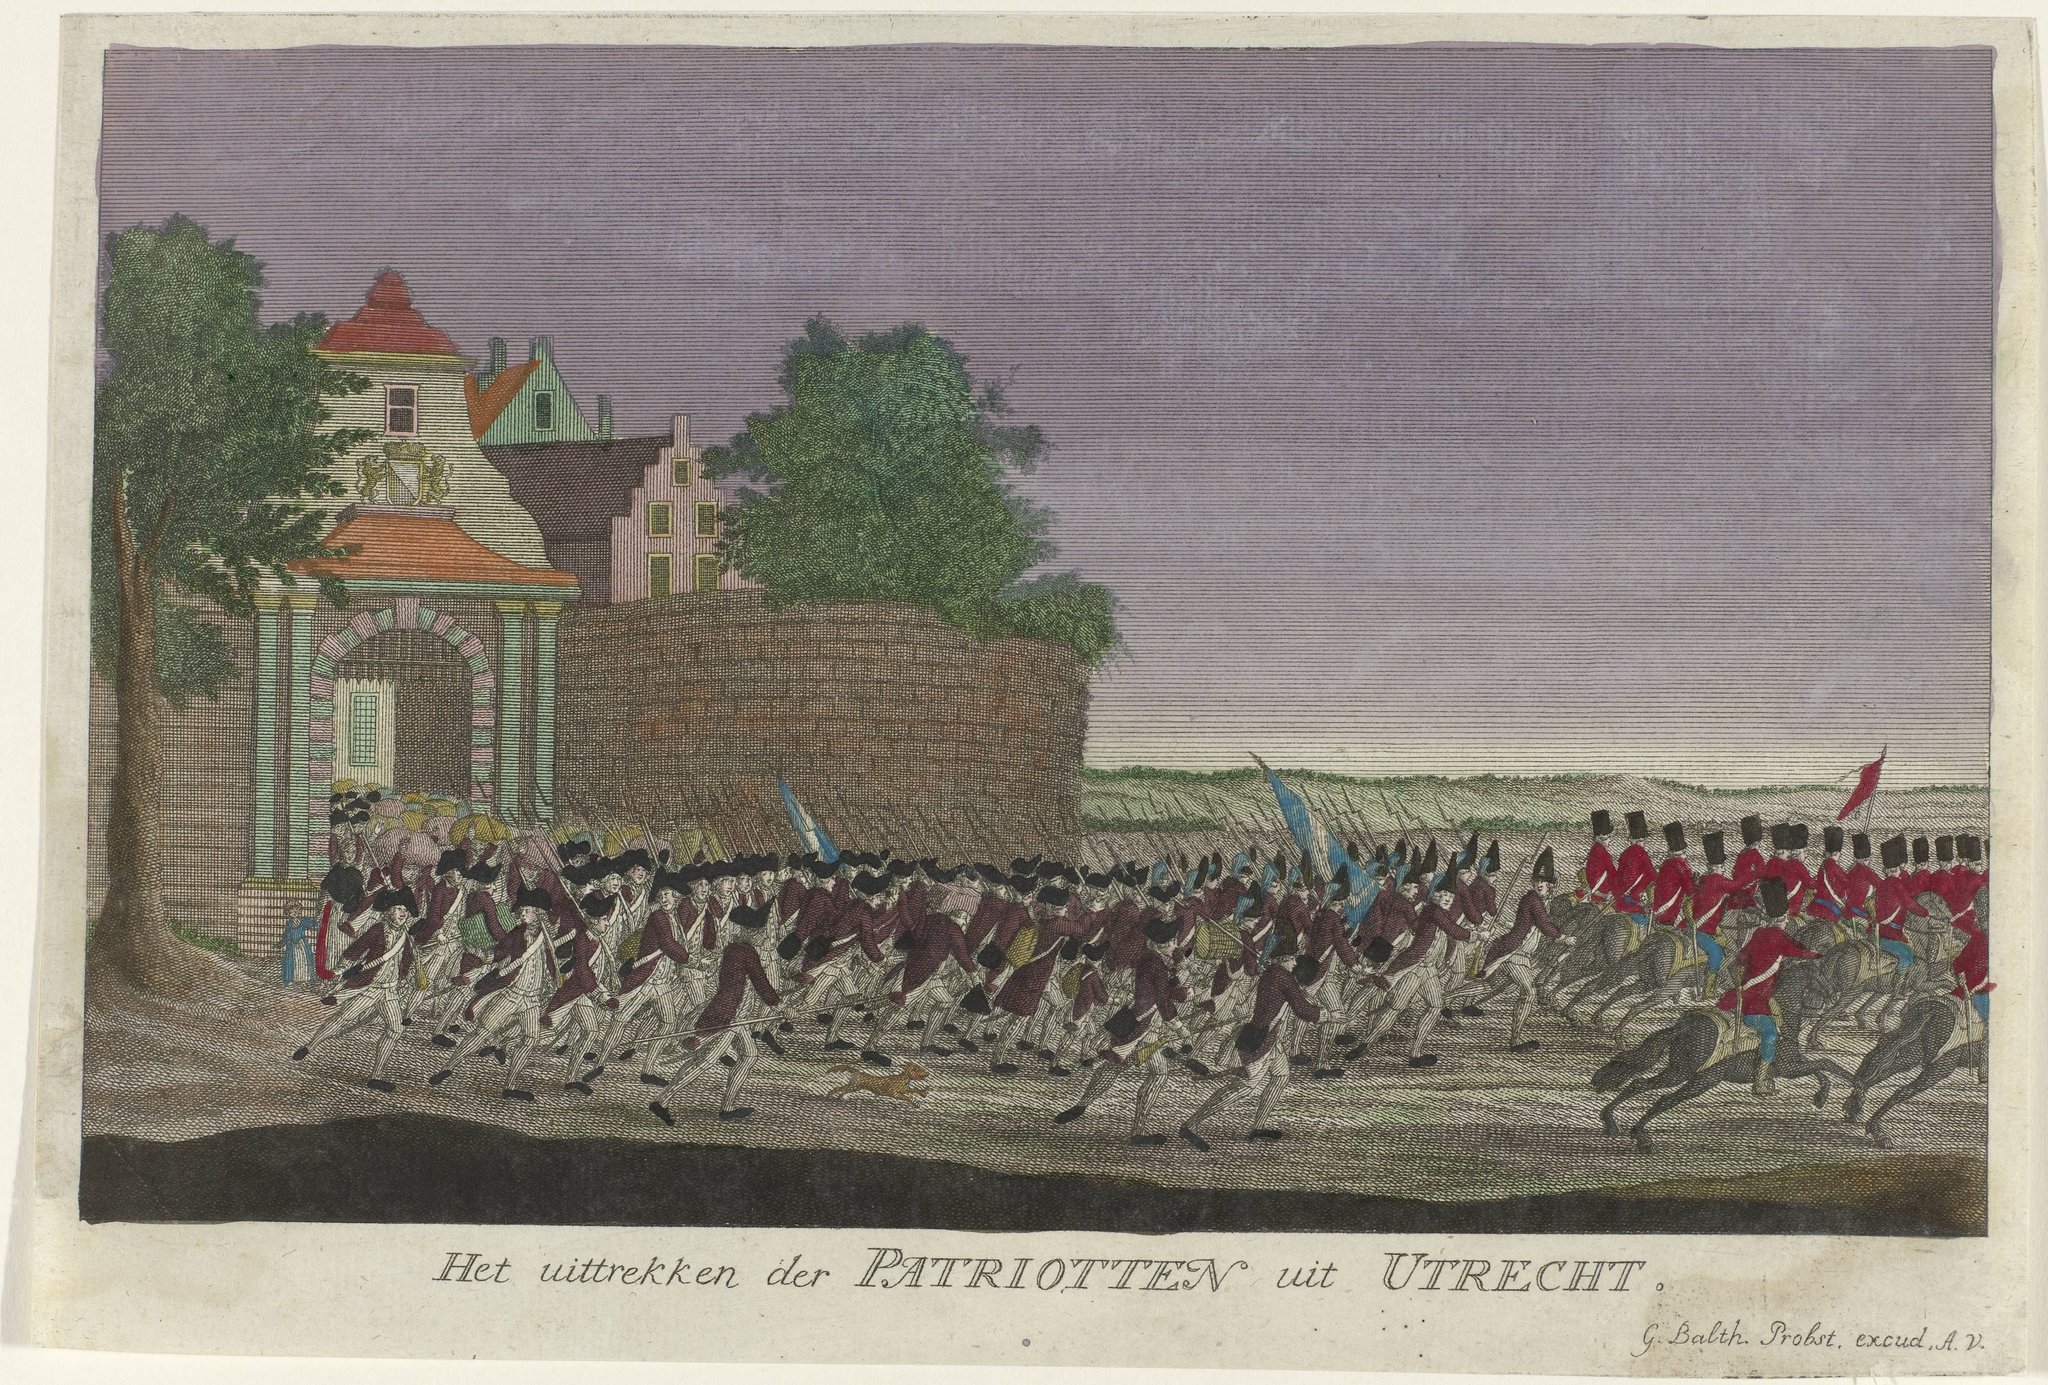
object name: print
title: Het uittrekken der Patriotten uit Utrecht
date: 1787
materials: paper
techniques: engraving, etching, hand coloring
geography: augsburg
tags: putting the enemy to flight - hh - being put to flight, fleeing (+ citizen soldiery, civil guard, citizen militia), utrecht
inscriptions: collector's mark: Lugt 2228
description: De legers van de patriotten verlaten in paniek door een stadspoort de stad Utrecht in de nacht van 15 op 16 september 1787 bij het naderen van de Pruisische troepen.